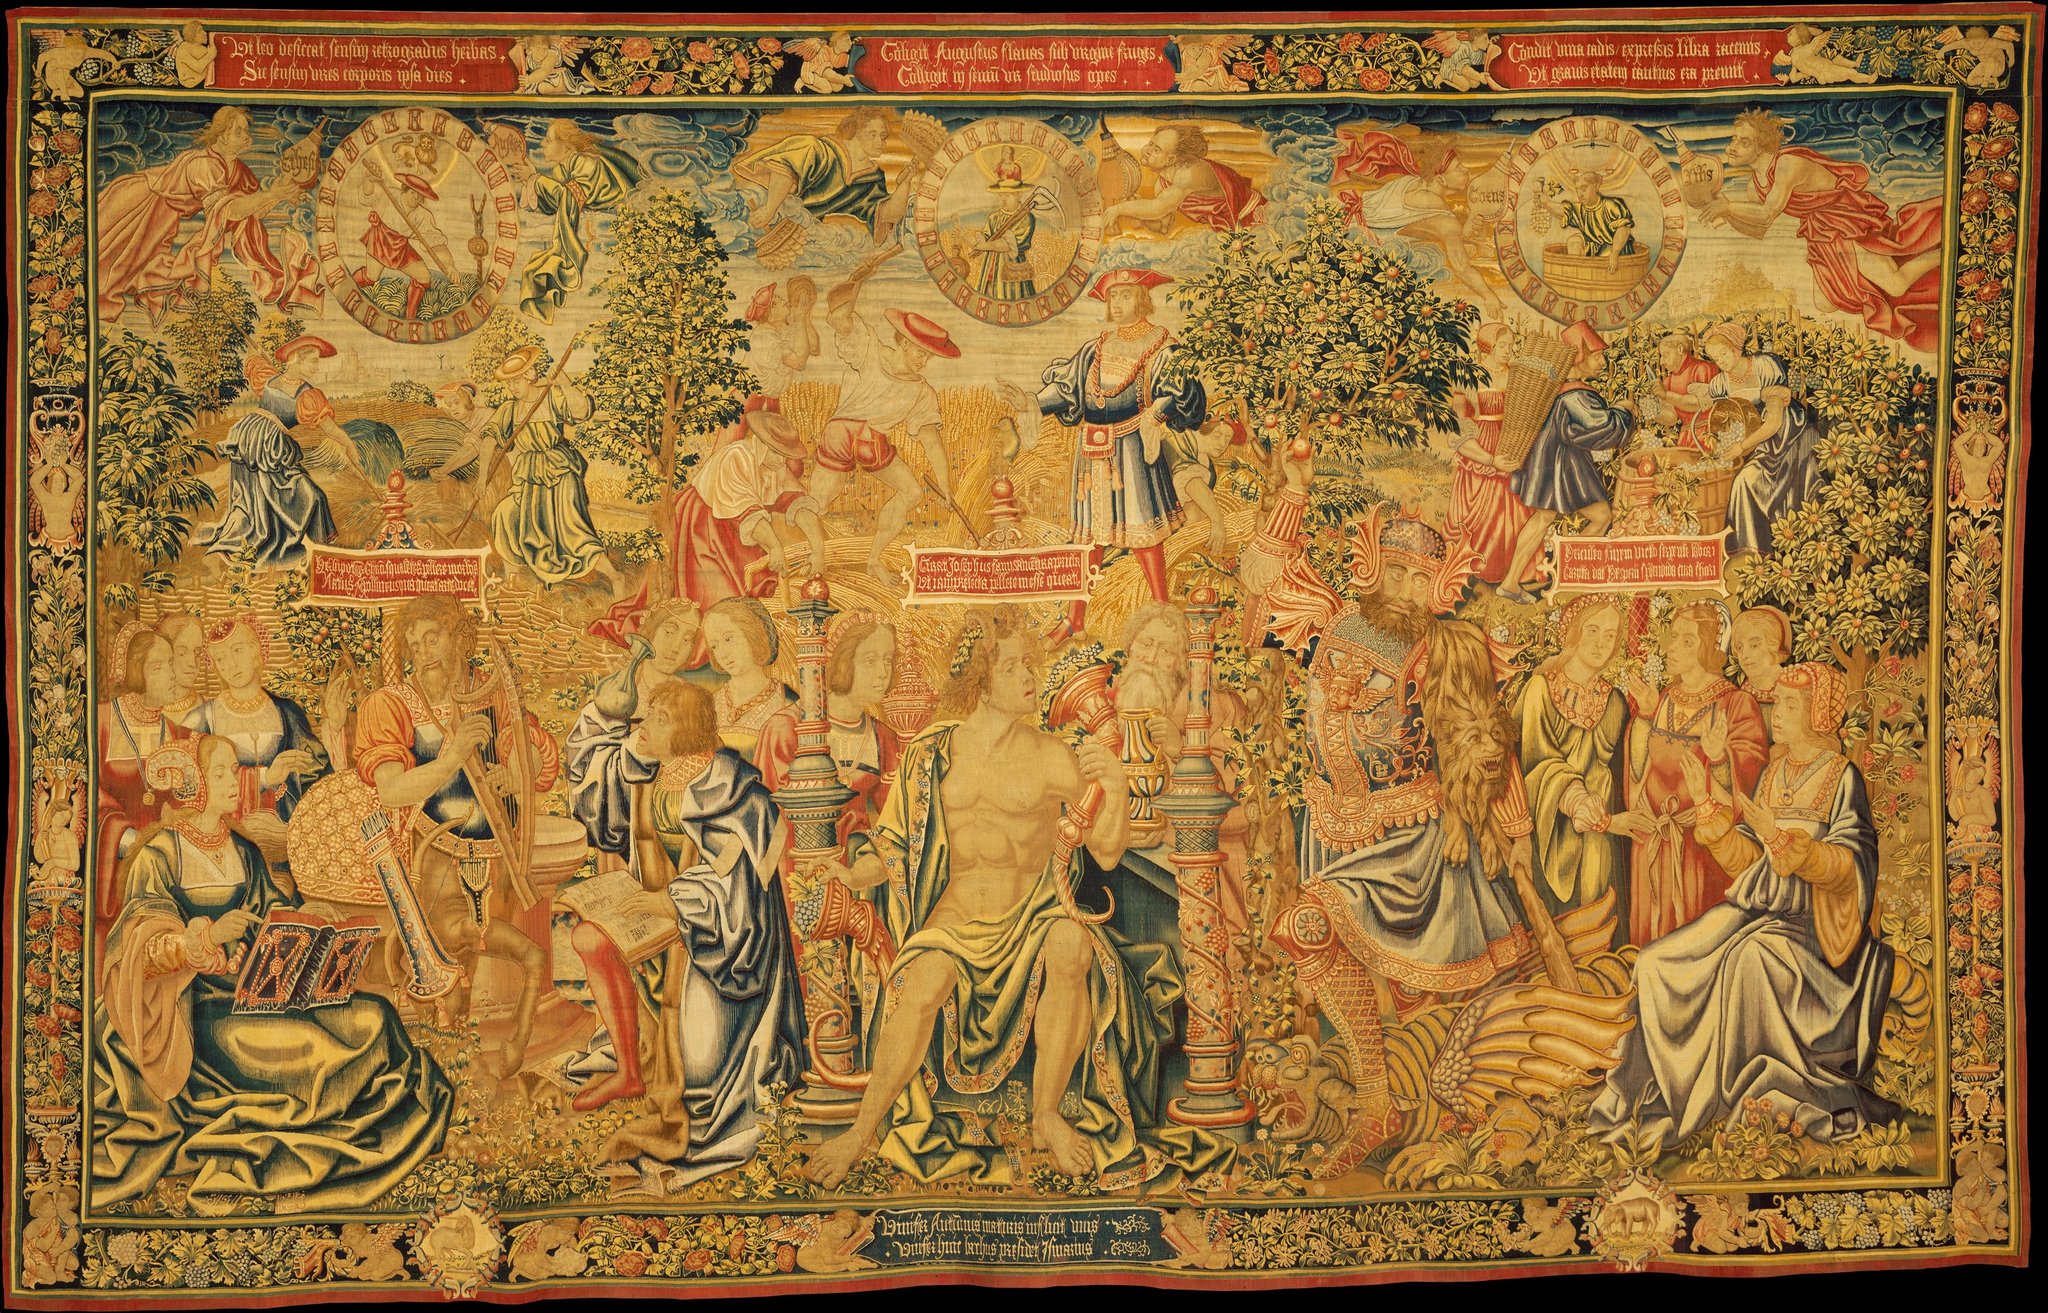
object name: tapestry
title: The Twelve Ages of a Man: The Second Three Ages (18-36), or Autumn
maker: bernard van orley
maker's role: designer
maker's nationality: netherlandish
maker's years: 1492-1542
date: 1515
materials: silk, wool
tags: hercules,centaurs,bacchus,flowers,trees